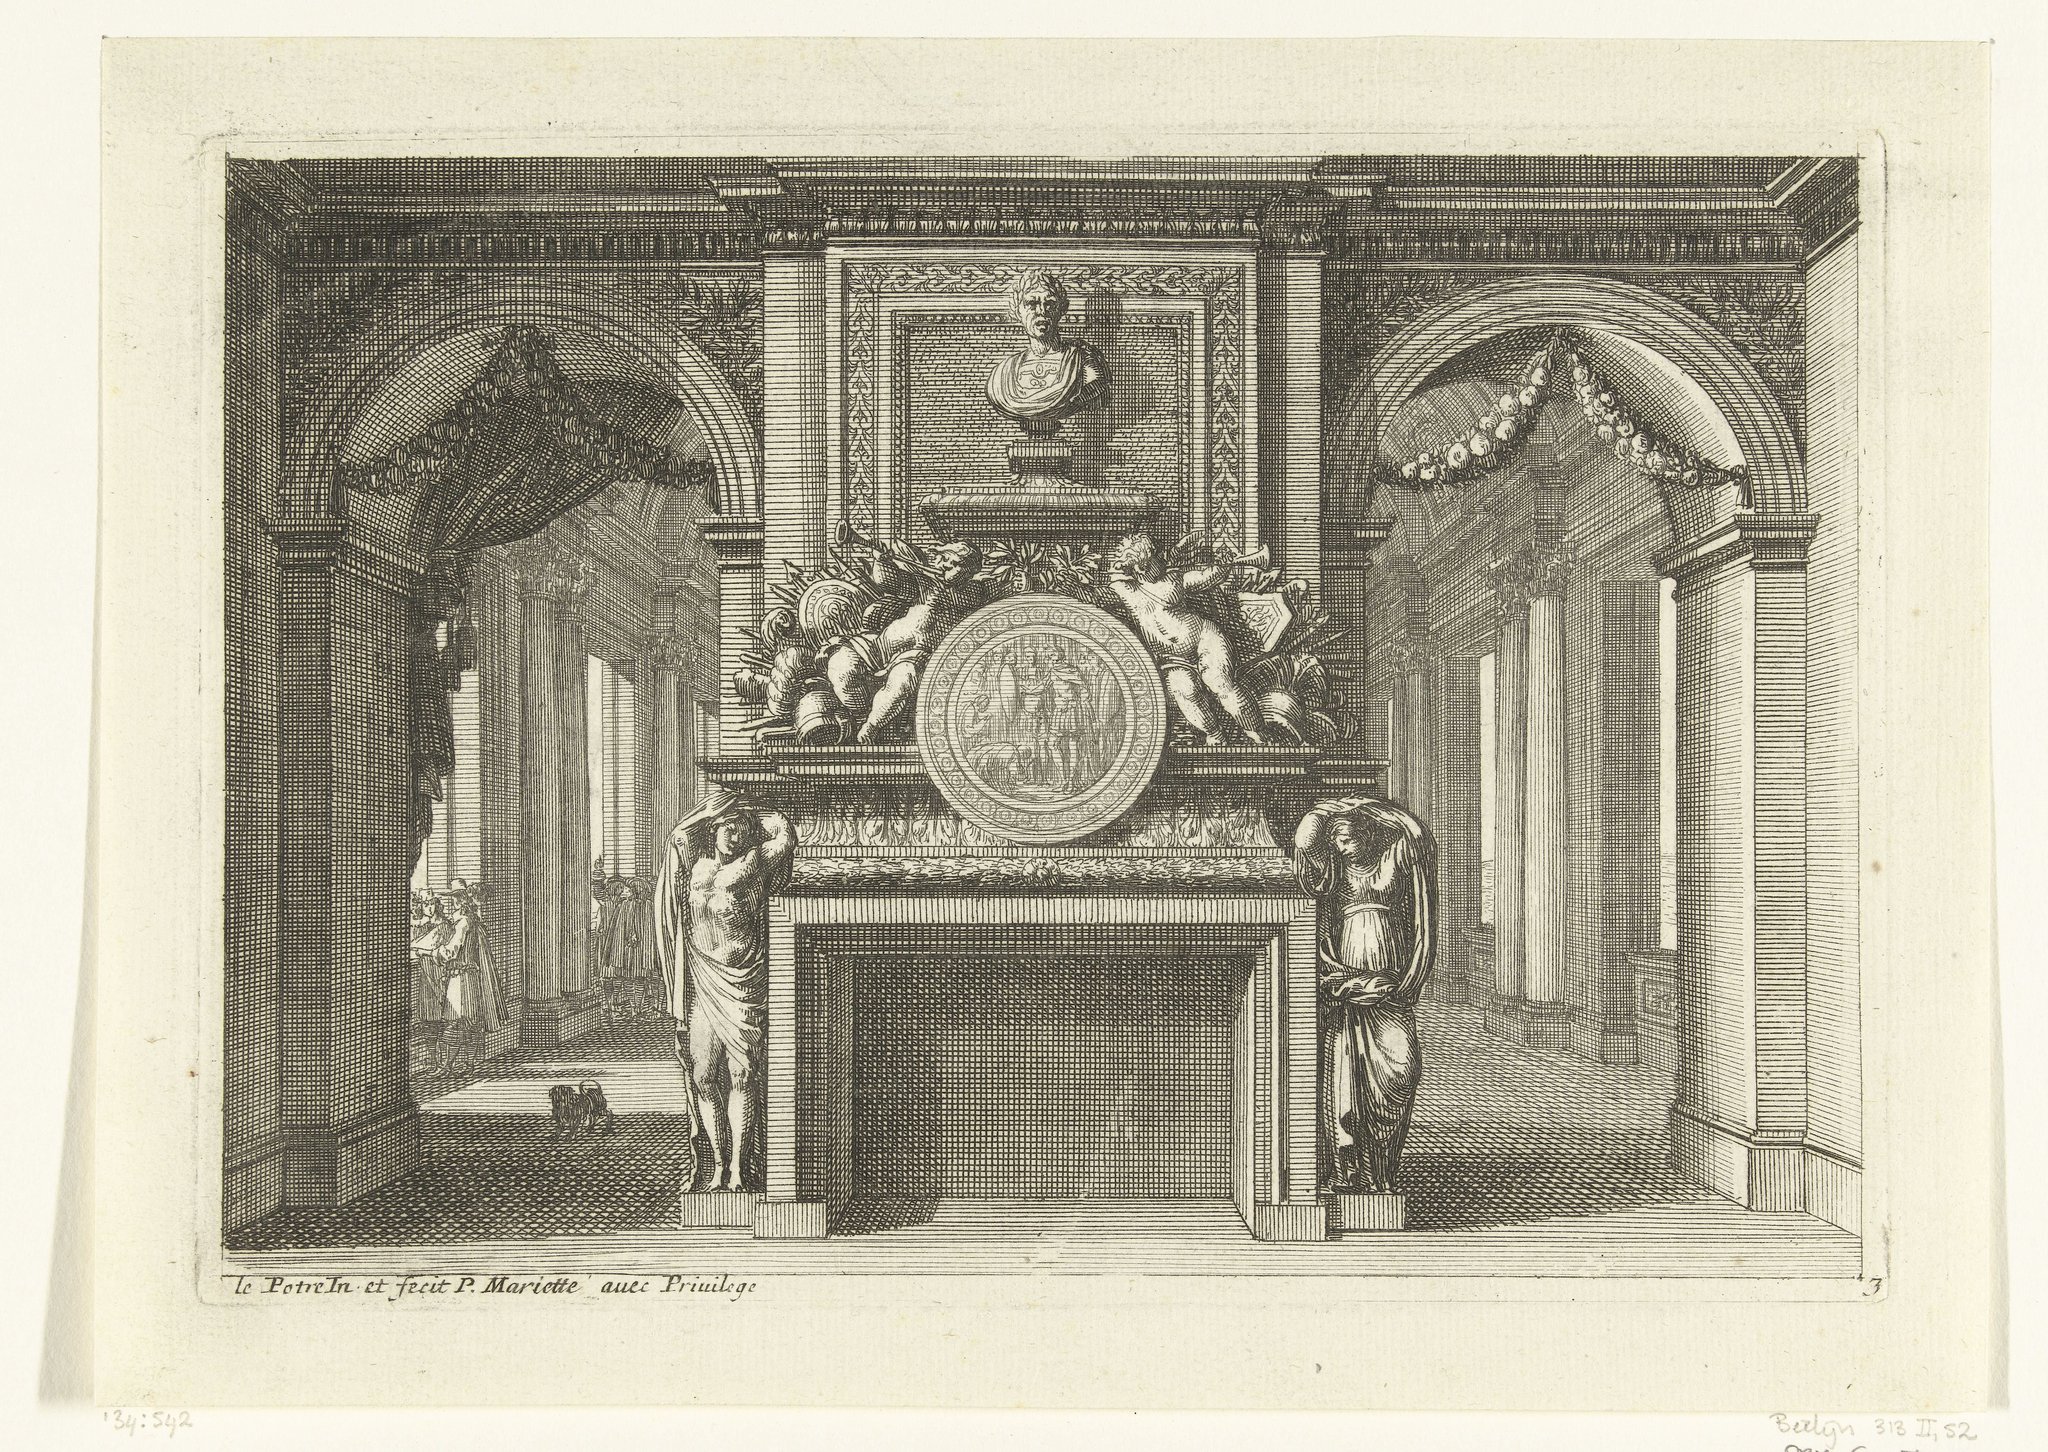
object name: ornament print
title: Cheminées et Lambris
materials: paper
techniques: etching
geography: france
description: De onderboezem staat tussen twee bogen die uitzicht bieden op een galerij. Uit tweede editie van serie bladen met onderboezems en houten lambrisering.